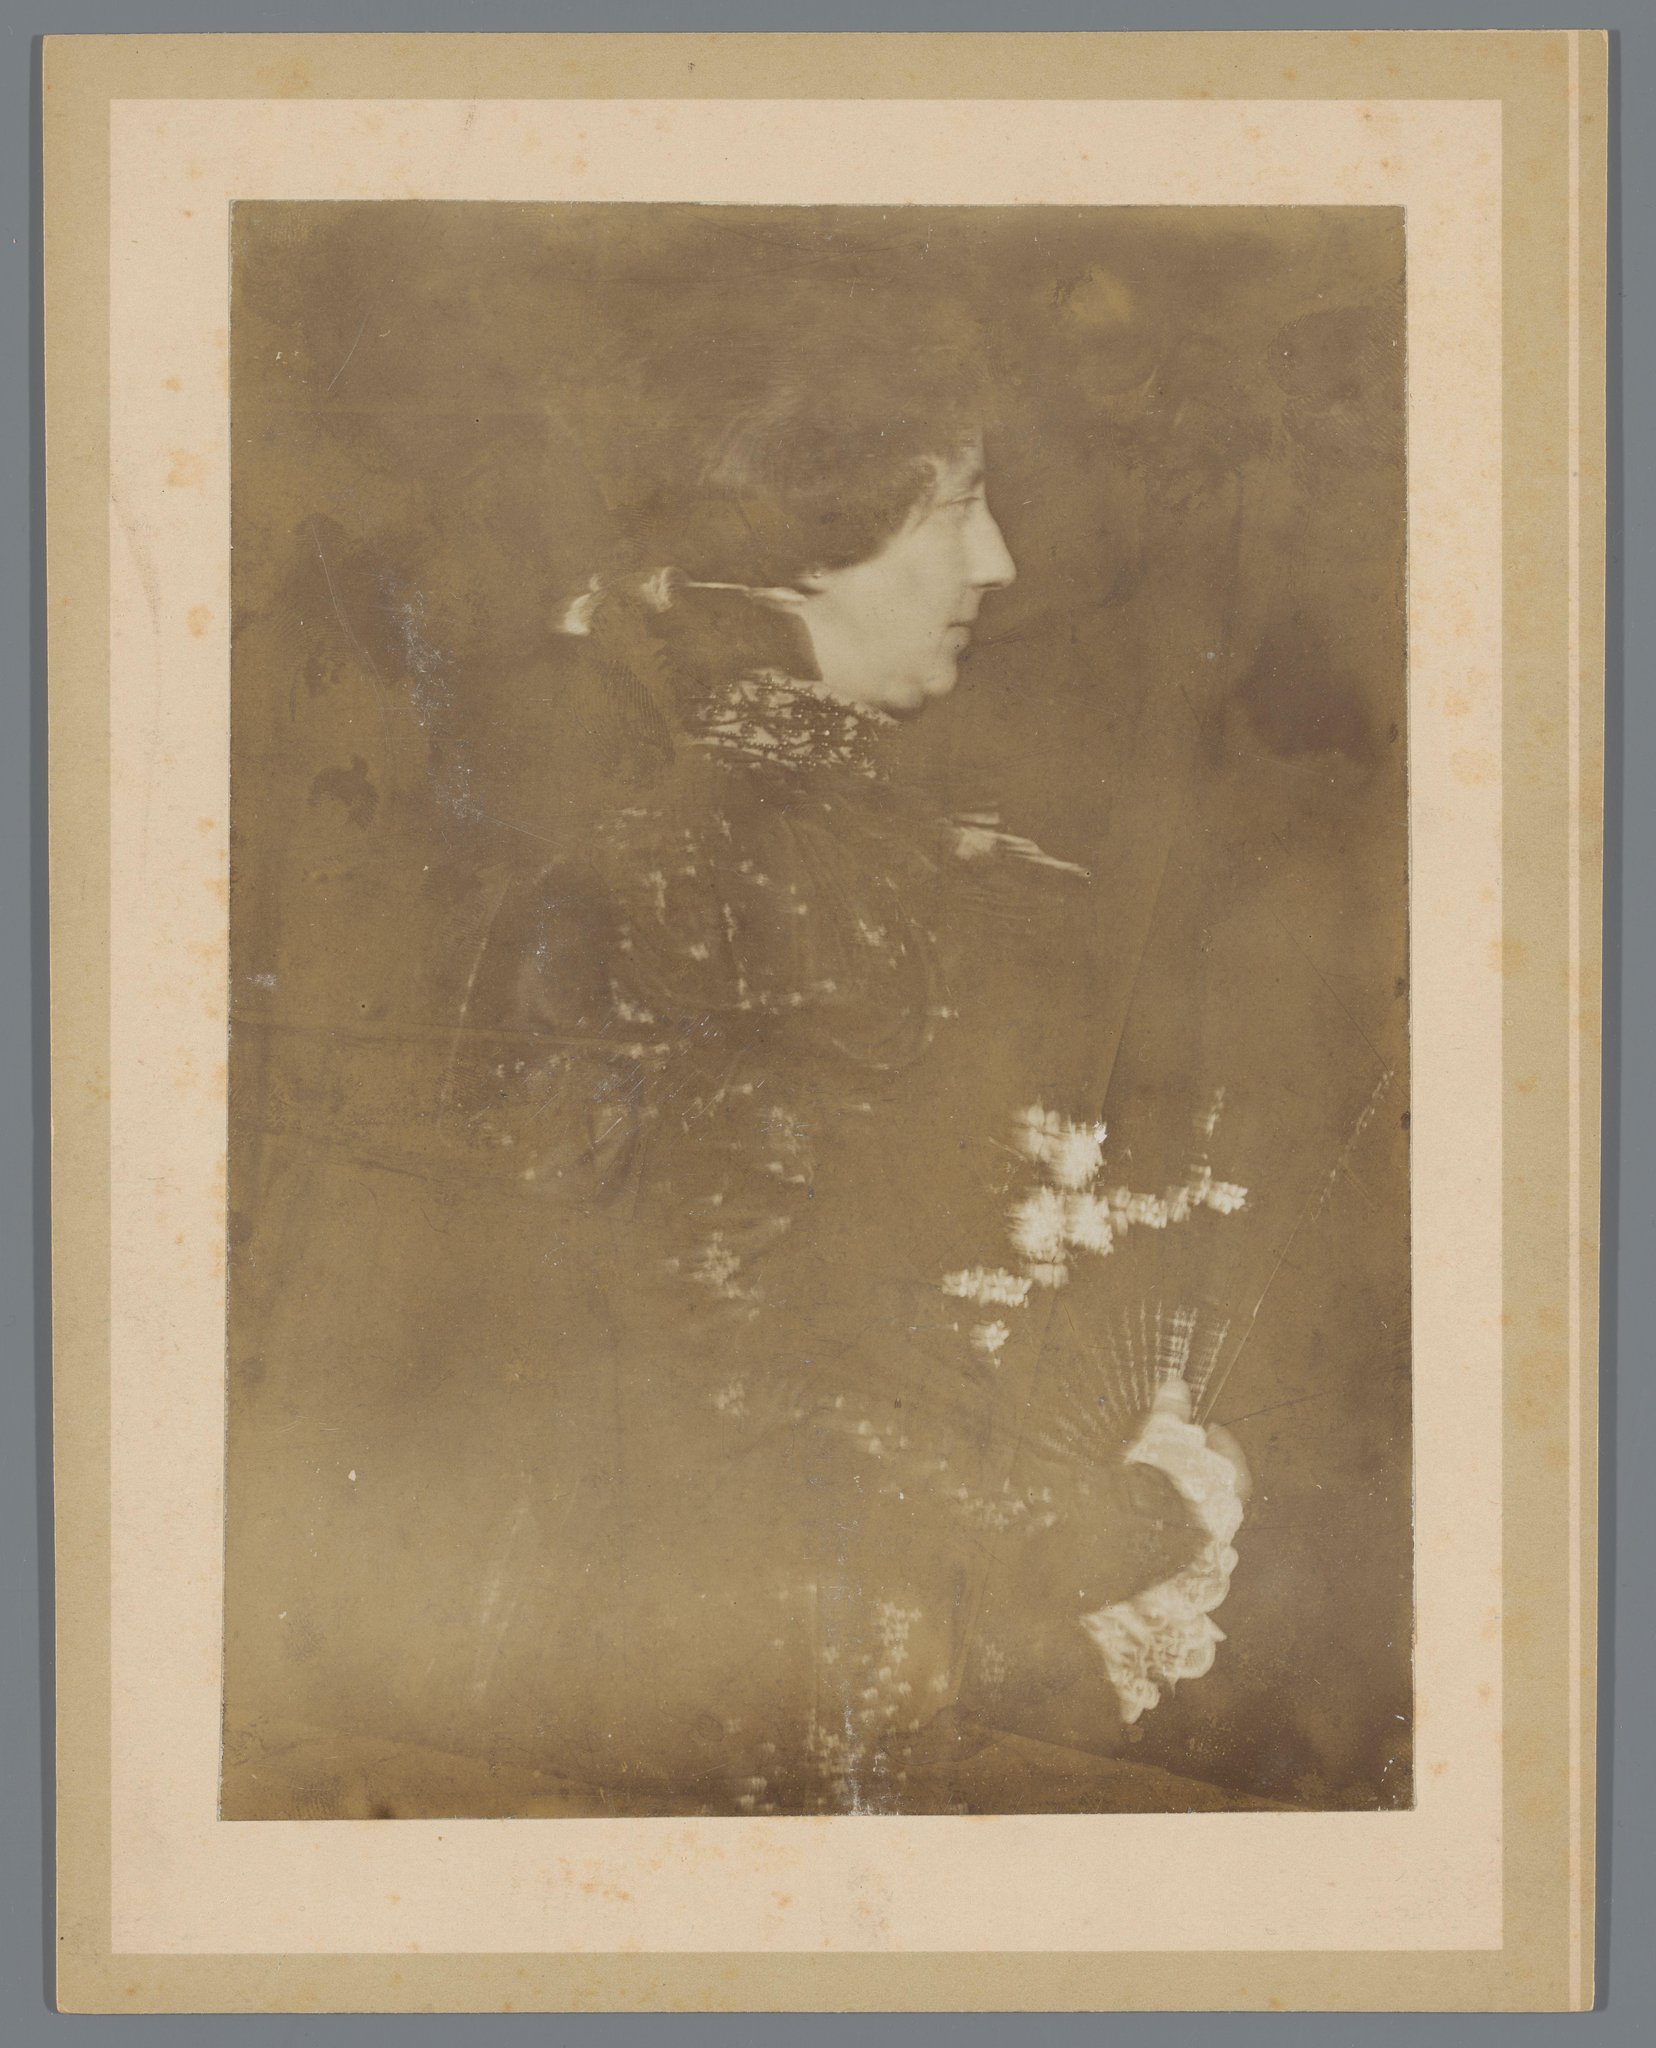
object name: photograph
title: Portret van Johanna Stam, de echtgenote van de schilder Herman van der Weele, met een geopende waaier in haar hand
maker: Anonymous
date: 1880-1900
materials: paper, cardboard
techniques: collodion silver print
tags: historical persons - bb - woman, fan